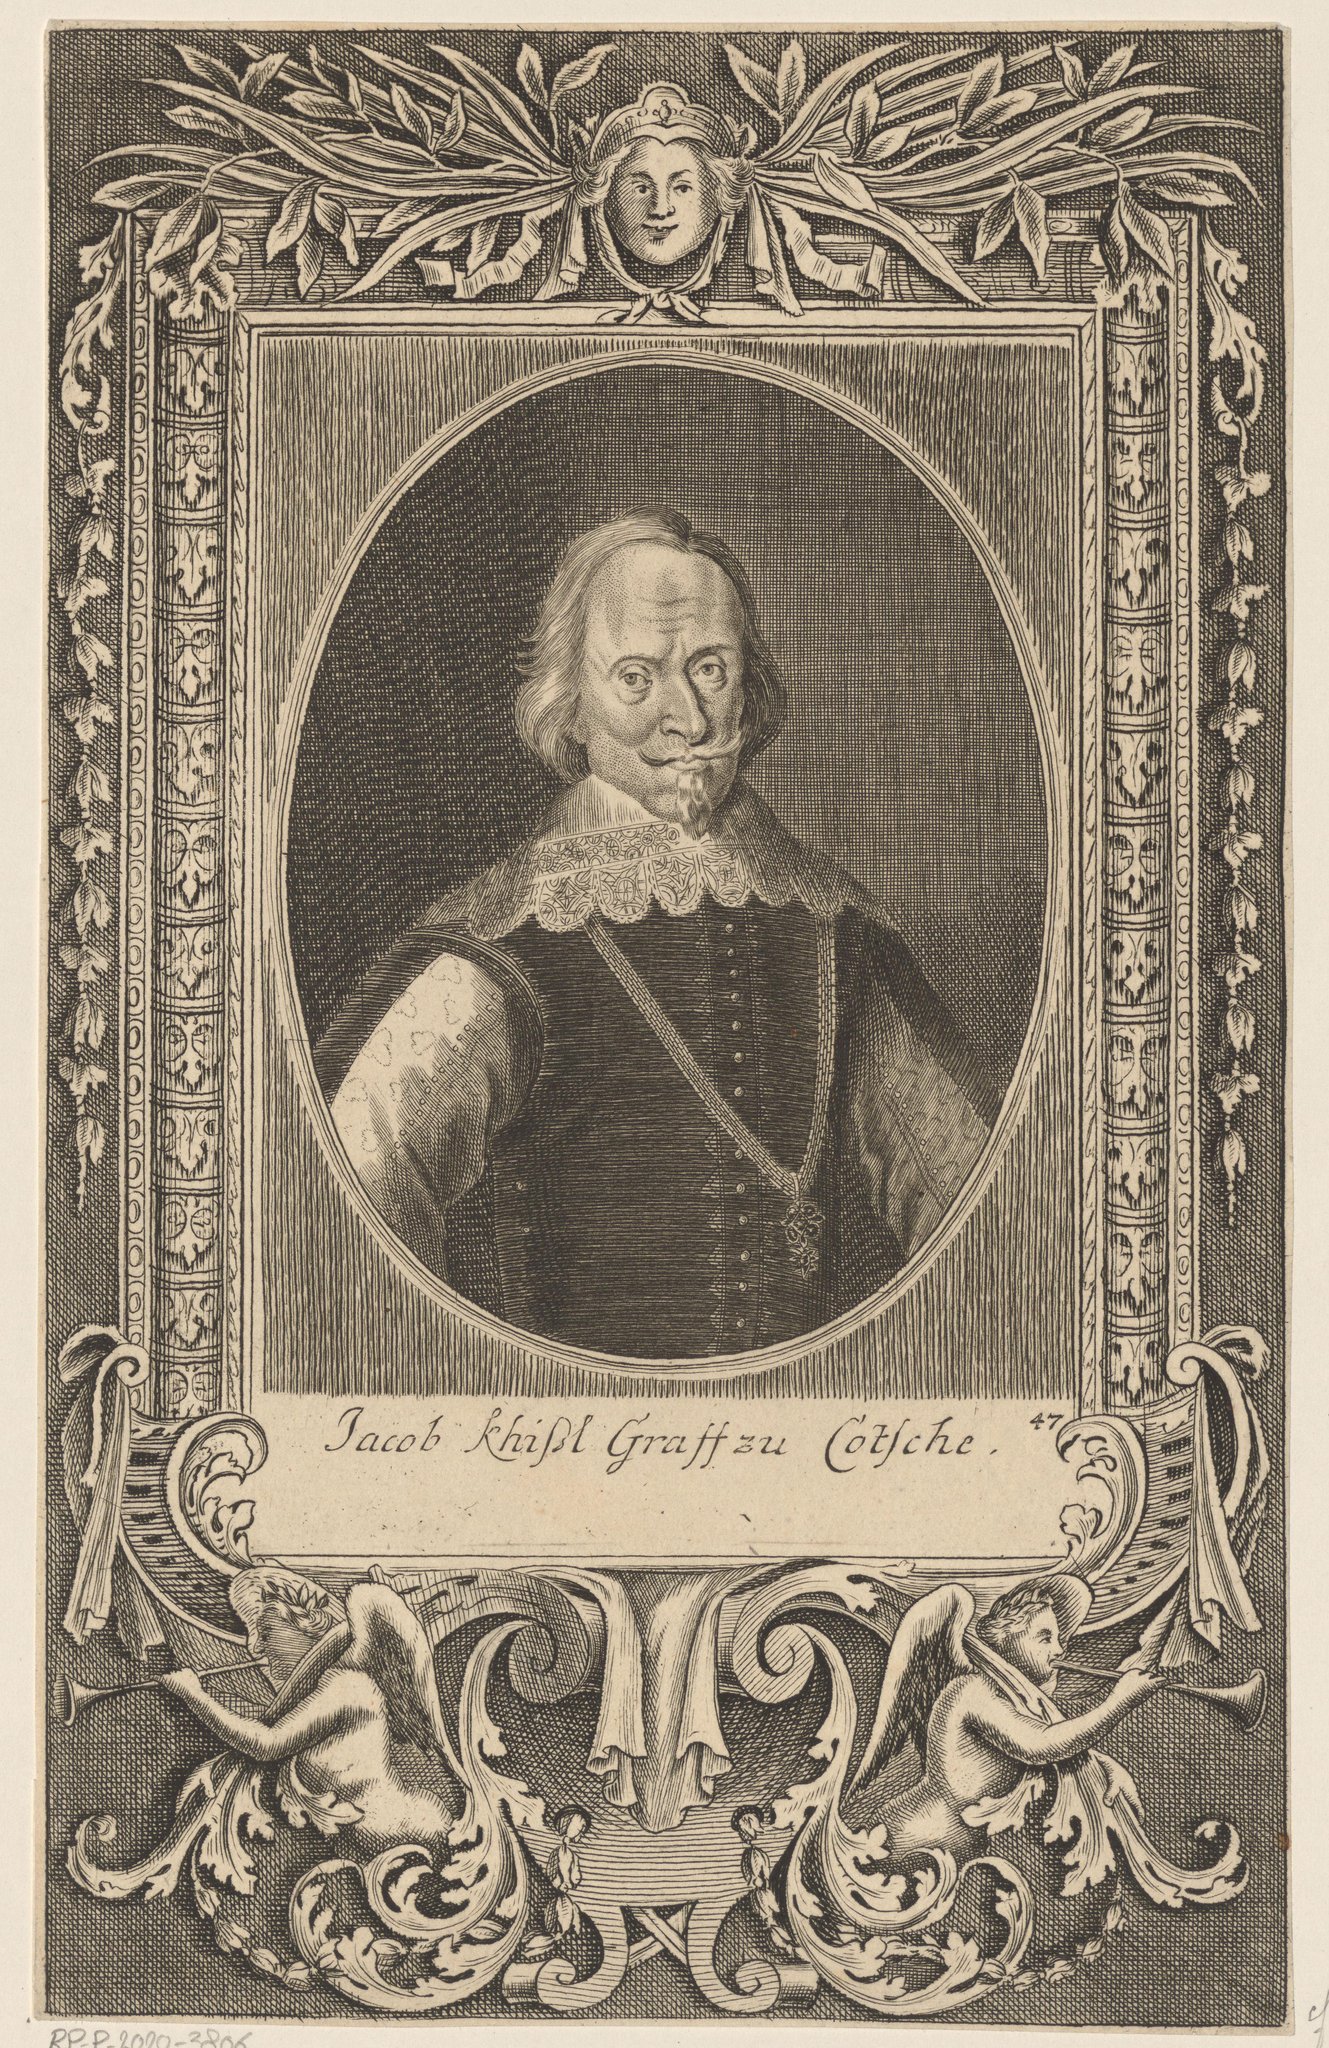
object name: print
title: Portret van Hanns Jakob Khiesel, graaf von Kaltenbrunn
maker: Anonymous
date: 1722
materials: paper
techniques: engraving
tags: historical persons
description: Prent met andere omlijsting uit: Annales Ferdinandei: So von Kaeysers Ferdinand deß Andern Geburt. Leipzig: Moritz Georg Weidmann, 1722, dl. 2.